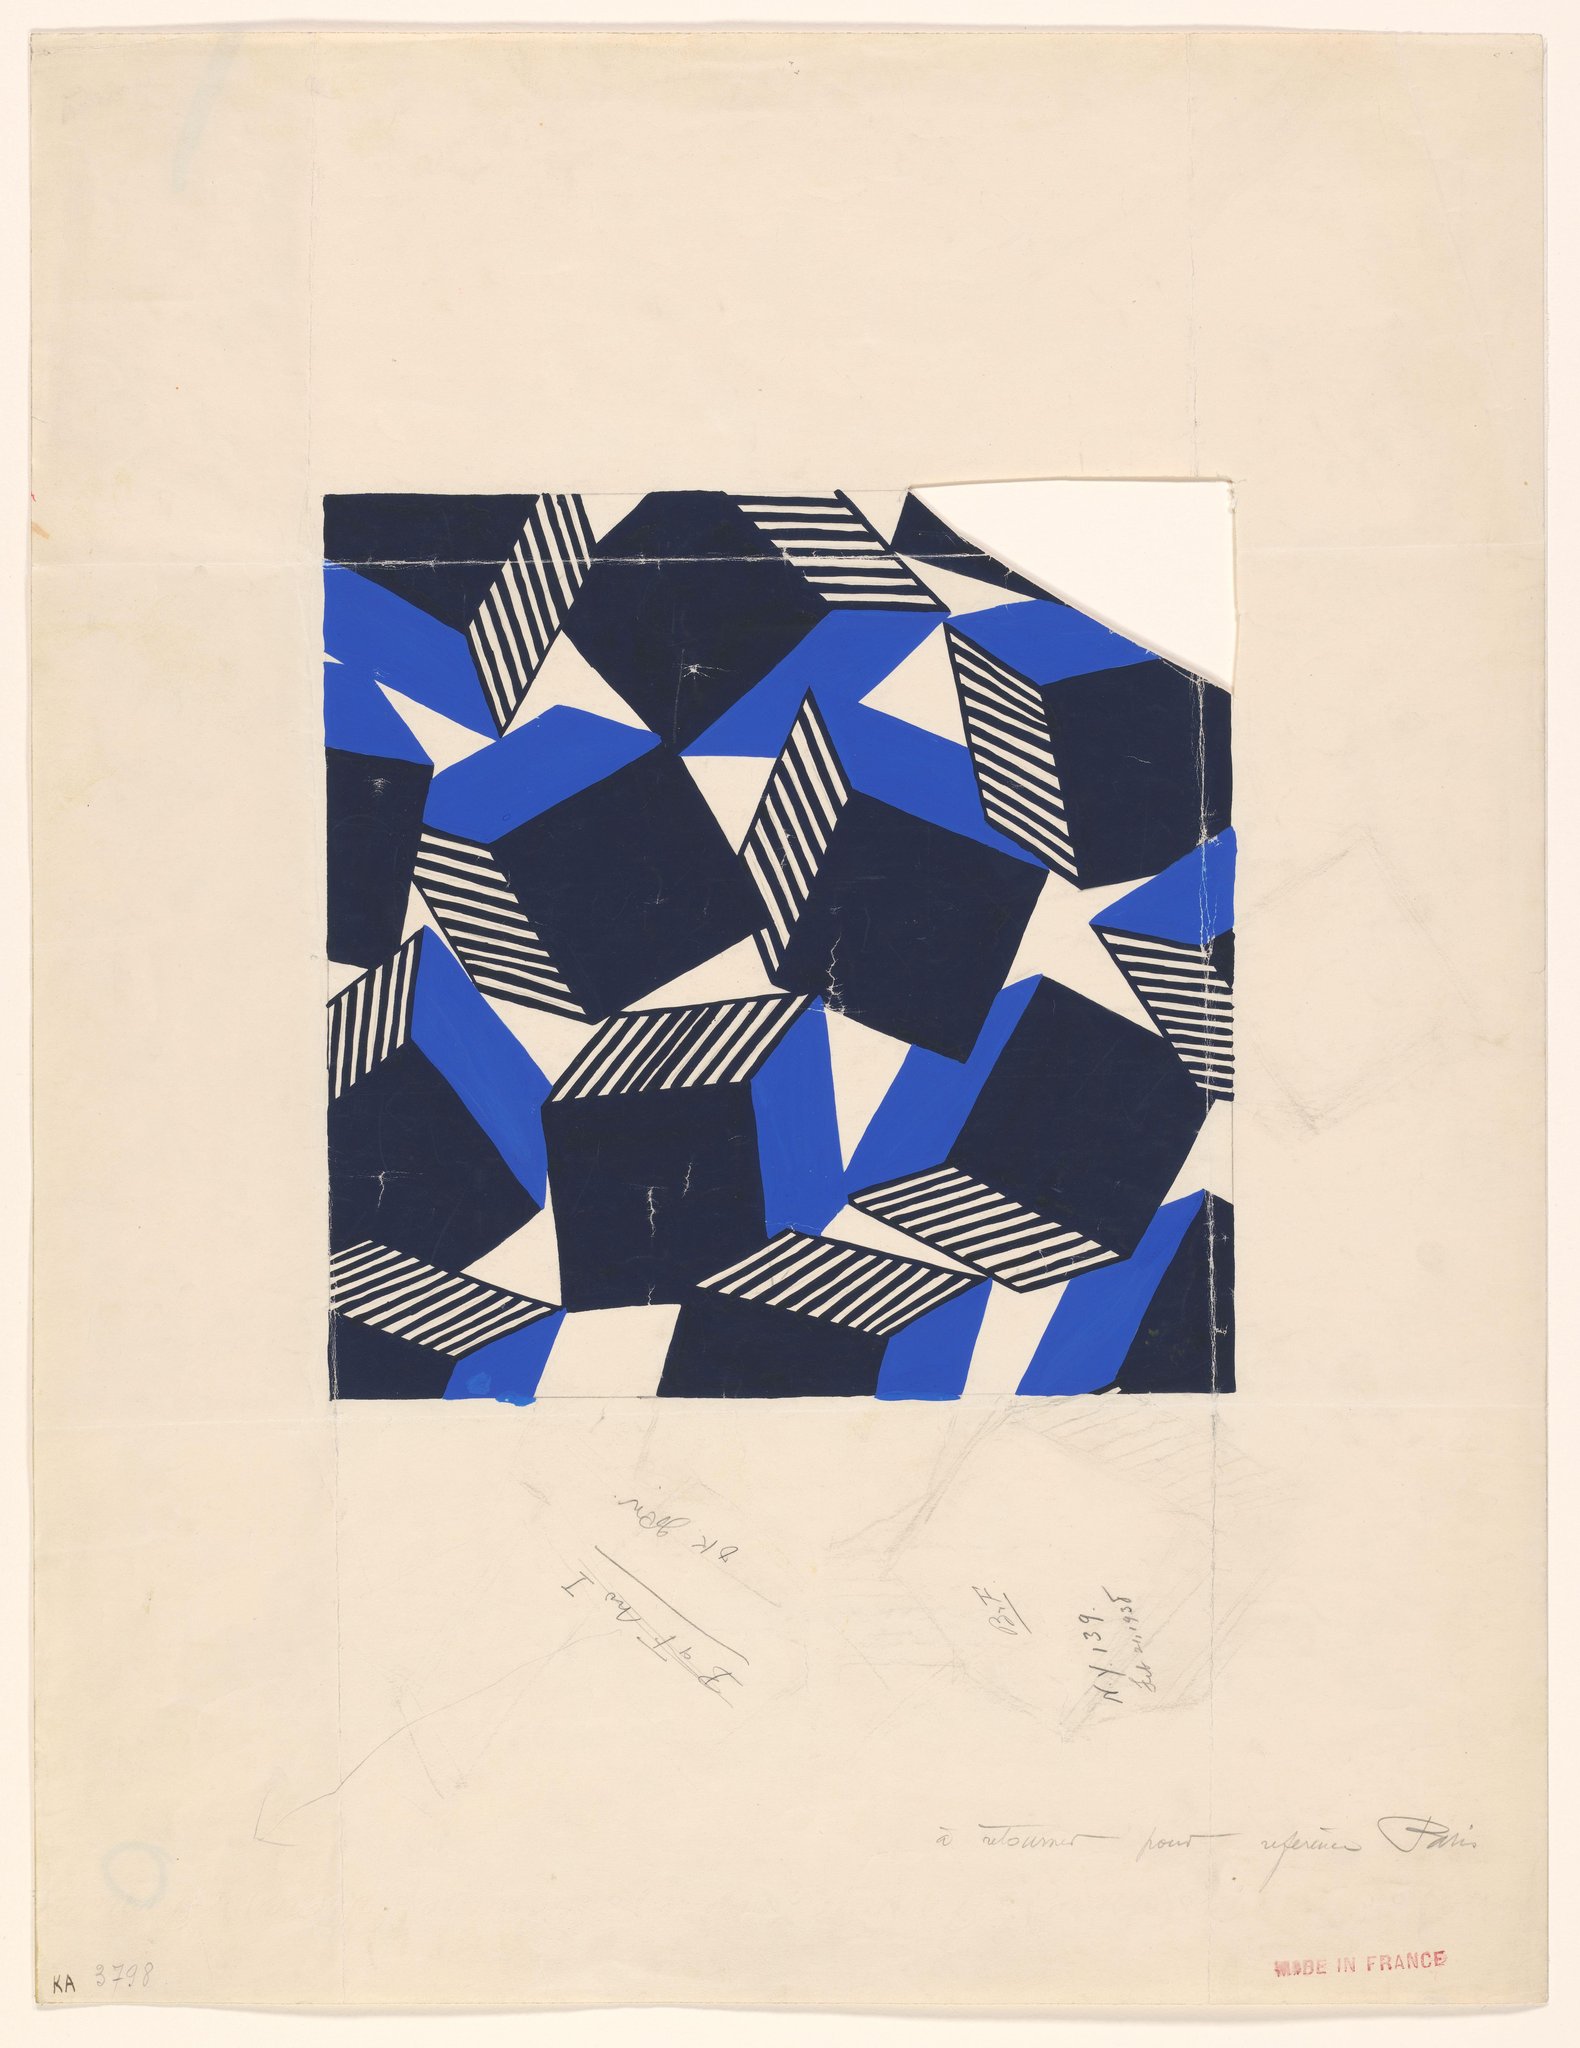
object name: design drawing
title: Ontwerp voor een zijden stof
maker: Anonymous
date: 1938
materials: gouache, graphite, paper, plastic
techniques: snipping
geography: lyon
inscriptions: inscription: ‘OK JRW [?] / B&F / N.Y. 139. / Feb 21, 1938 / à retourner pour reférence Paris’, inscription: ‘Bianchini / 1155’, number: ‘3798’, stamp: ‘MADE IN FRANCE’, inscription: ‘KA’, inscription: ‘B & F No I’